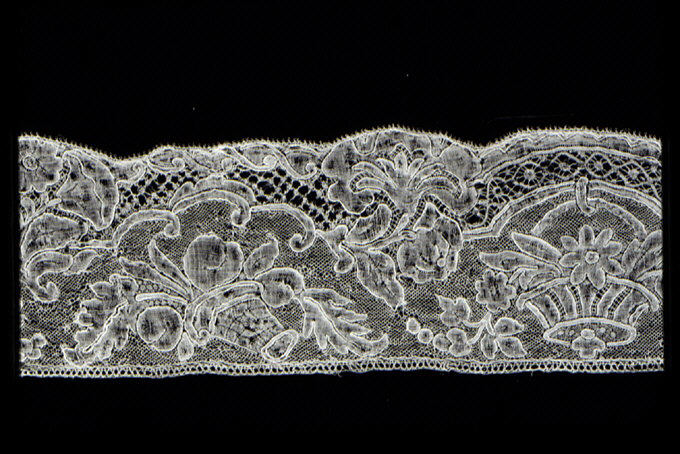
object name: fragment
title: Fragment of lace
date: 1734-1766